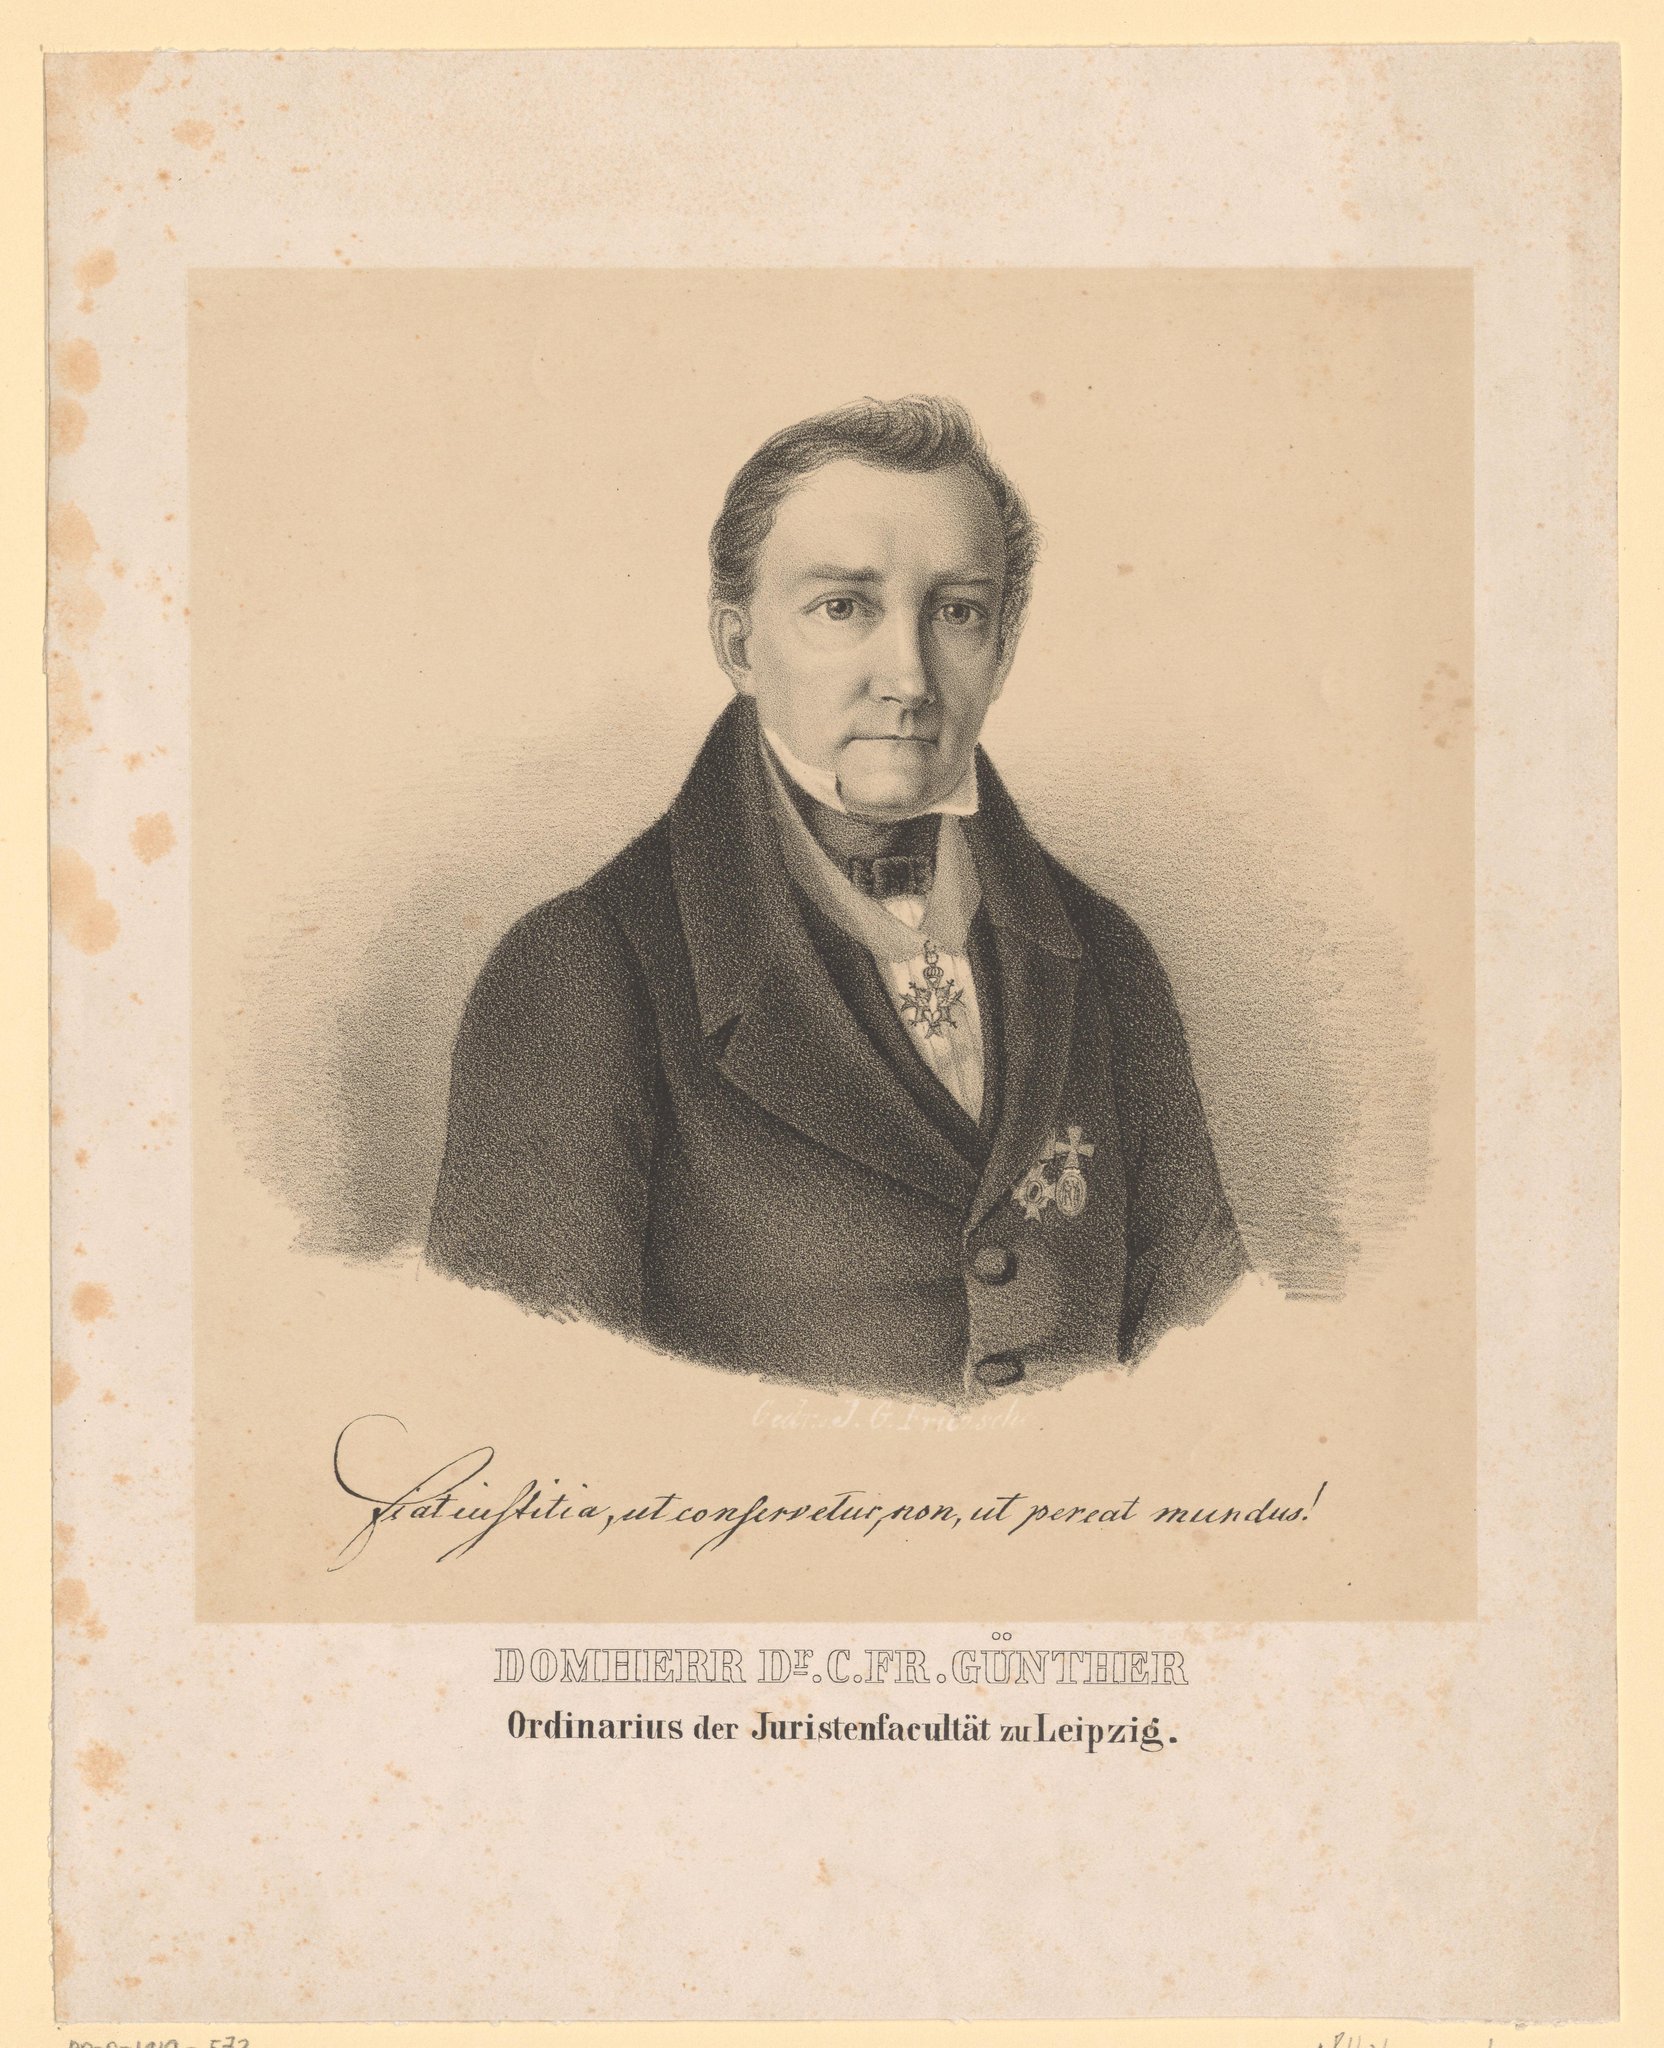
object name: print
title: Portret van Carl Friedrich Günther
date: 1848-1890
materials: paper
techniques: tone lithography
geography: leipzig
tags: politician, historical persons, politician, e.g. party leader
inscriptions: collector's mark: Lugt 2228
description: Onderschrift in facsimile. Tekst in het Duits in de ondermarge.